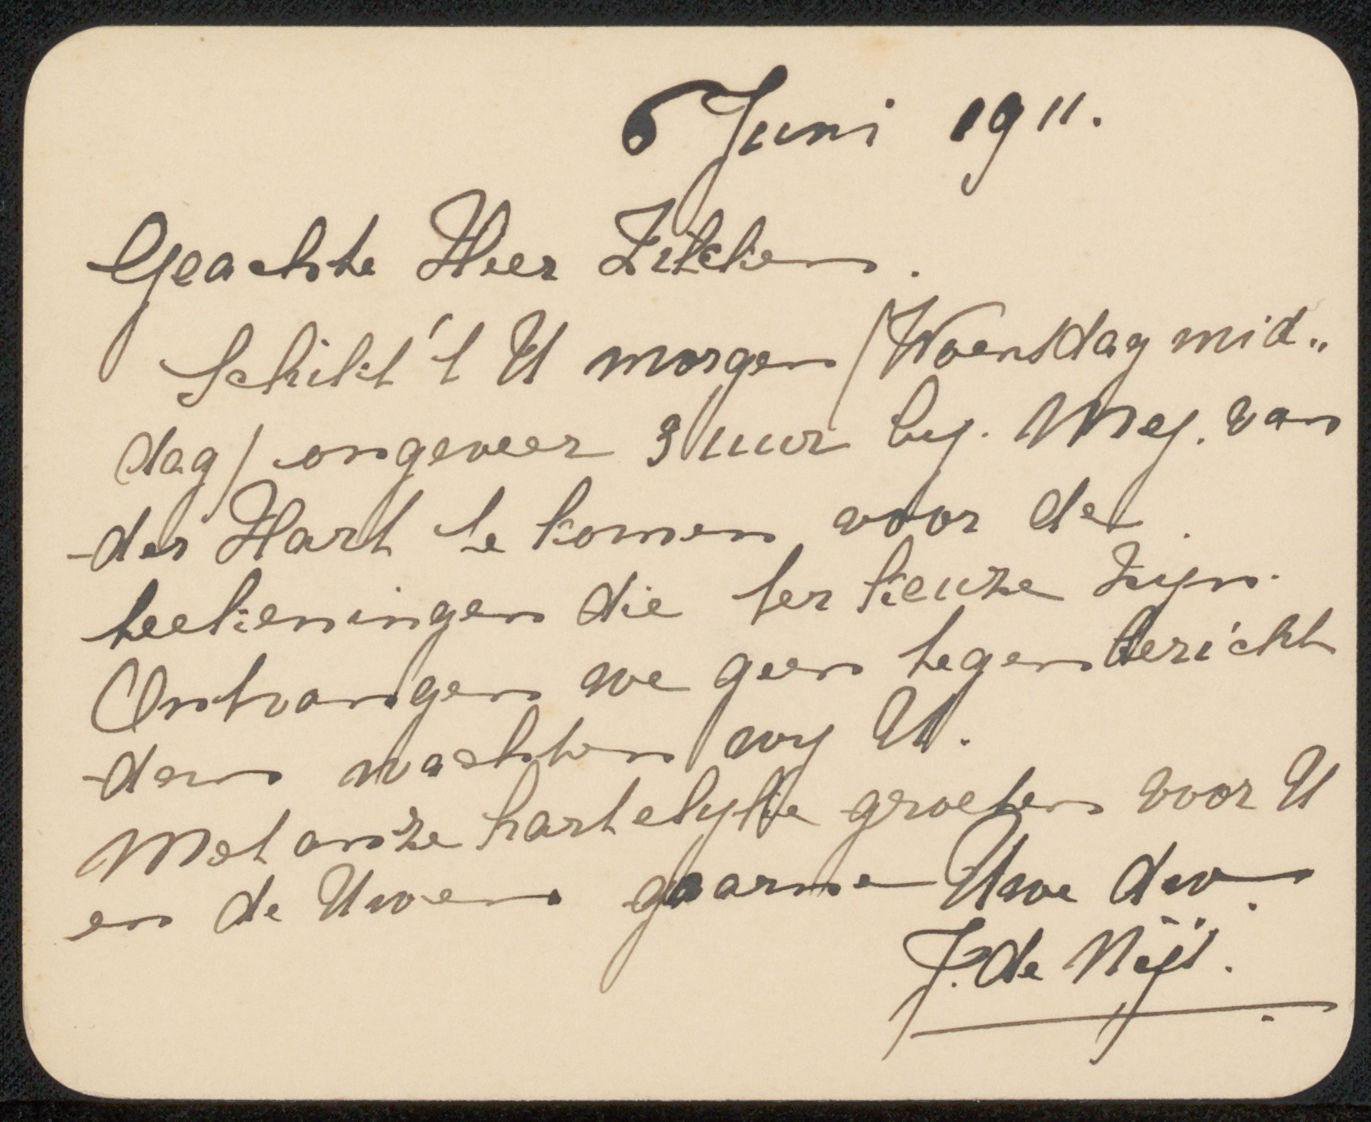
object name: letter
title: Brief aan Philip Zicken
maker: j. de nijs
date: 1911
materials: ink, paper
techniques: pen, writing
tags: the hague, painter, draughtsman, philip zilcken, drawing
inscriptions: collector's mark: ‘RPK’